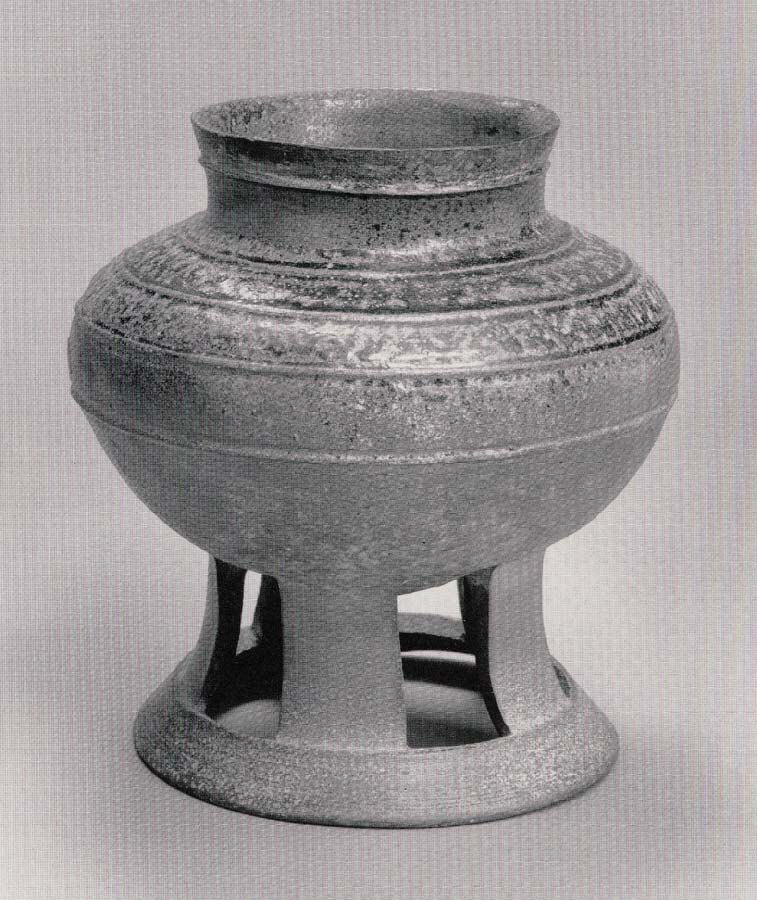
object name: cup, footed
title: Footed Cup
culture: japanese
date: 500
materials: wood, glaze, stoneware